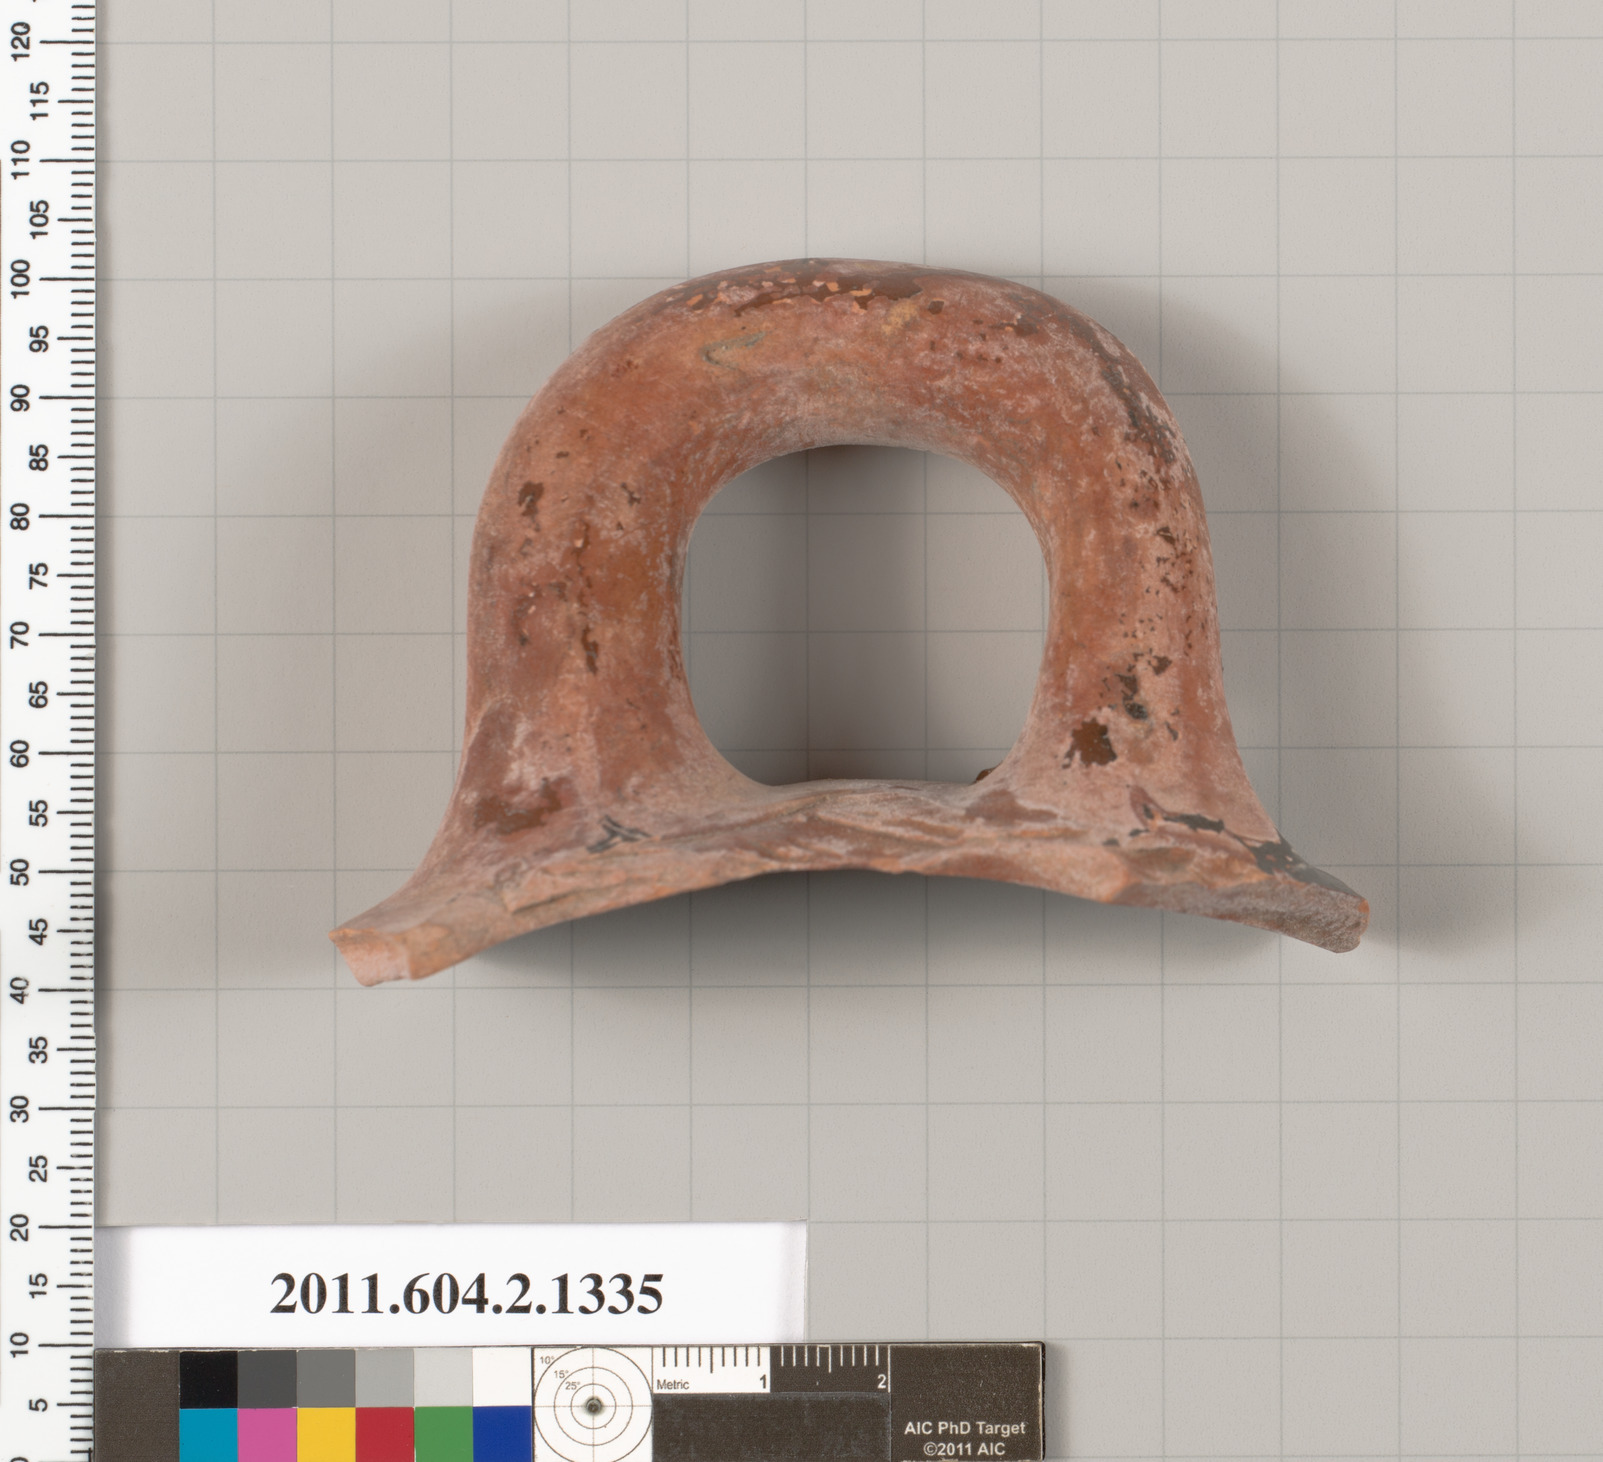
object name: skyphos fragment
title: Terracotta fragment of a skyphos (deep drinking cup)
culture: greek, attic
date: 500-451 BCE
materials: terracotta